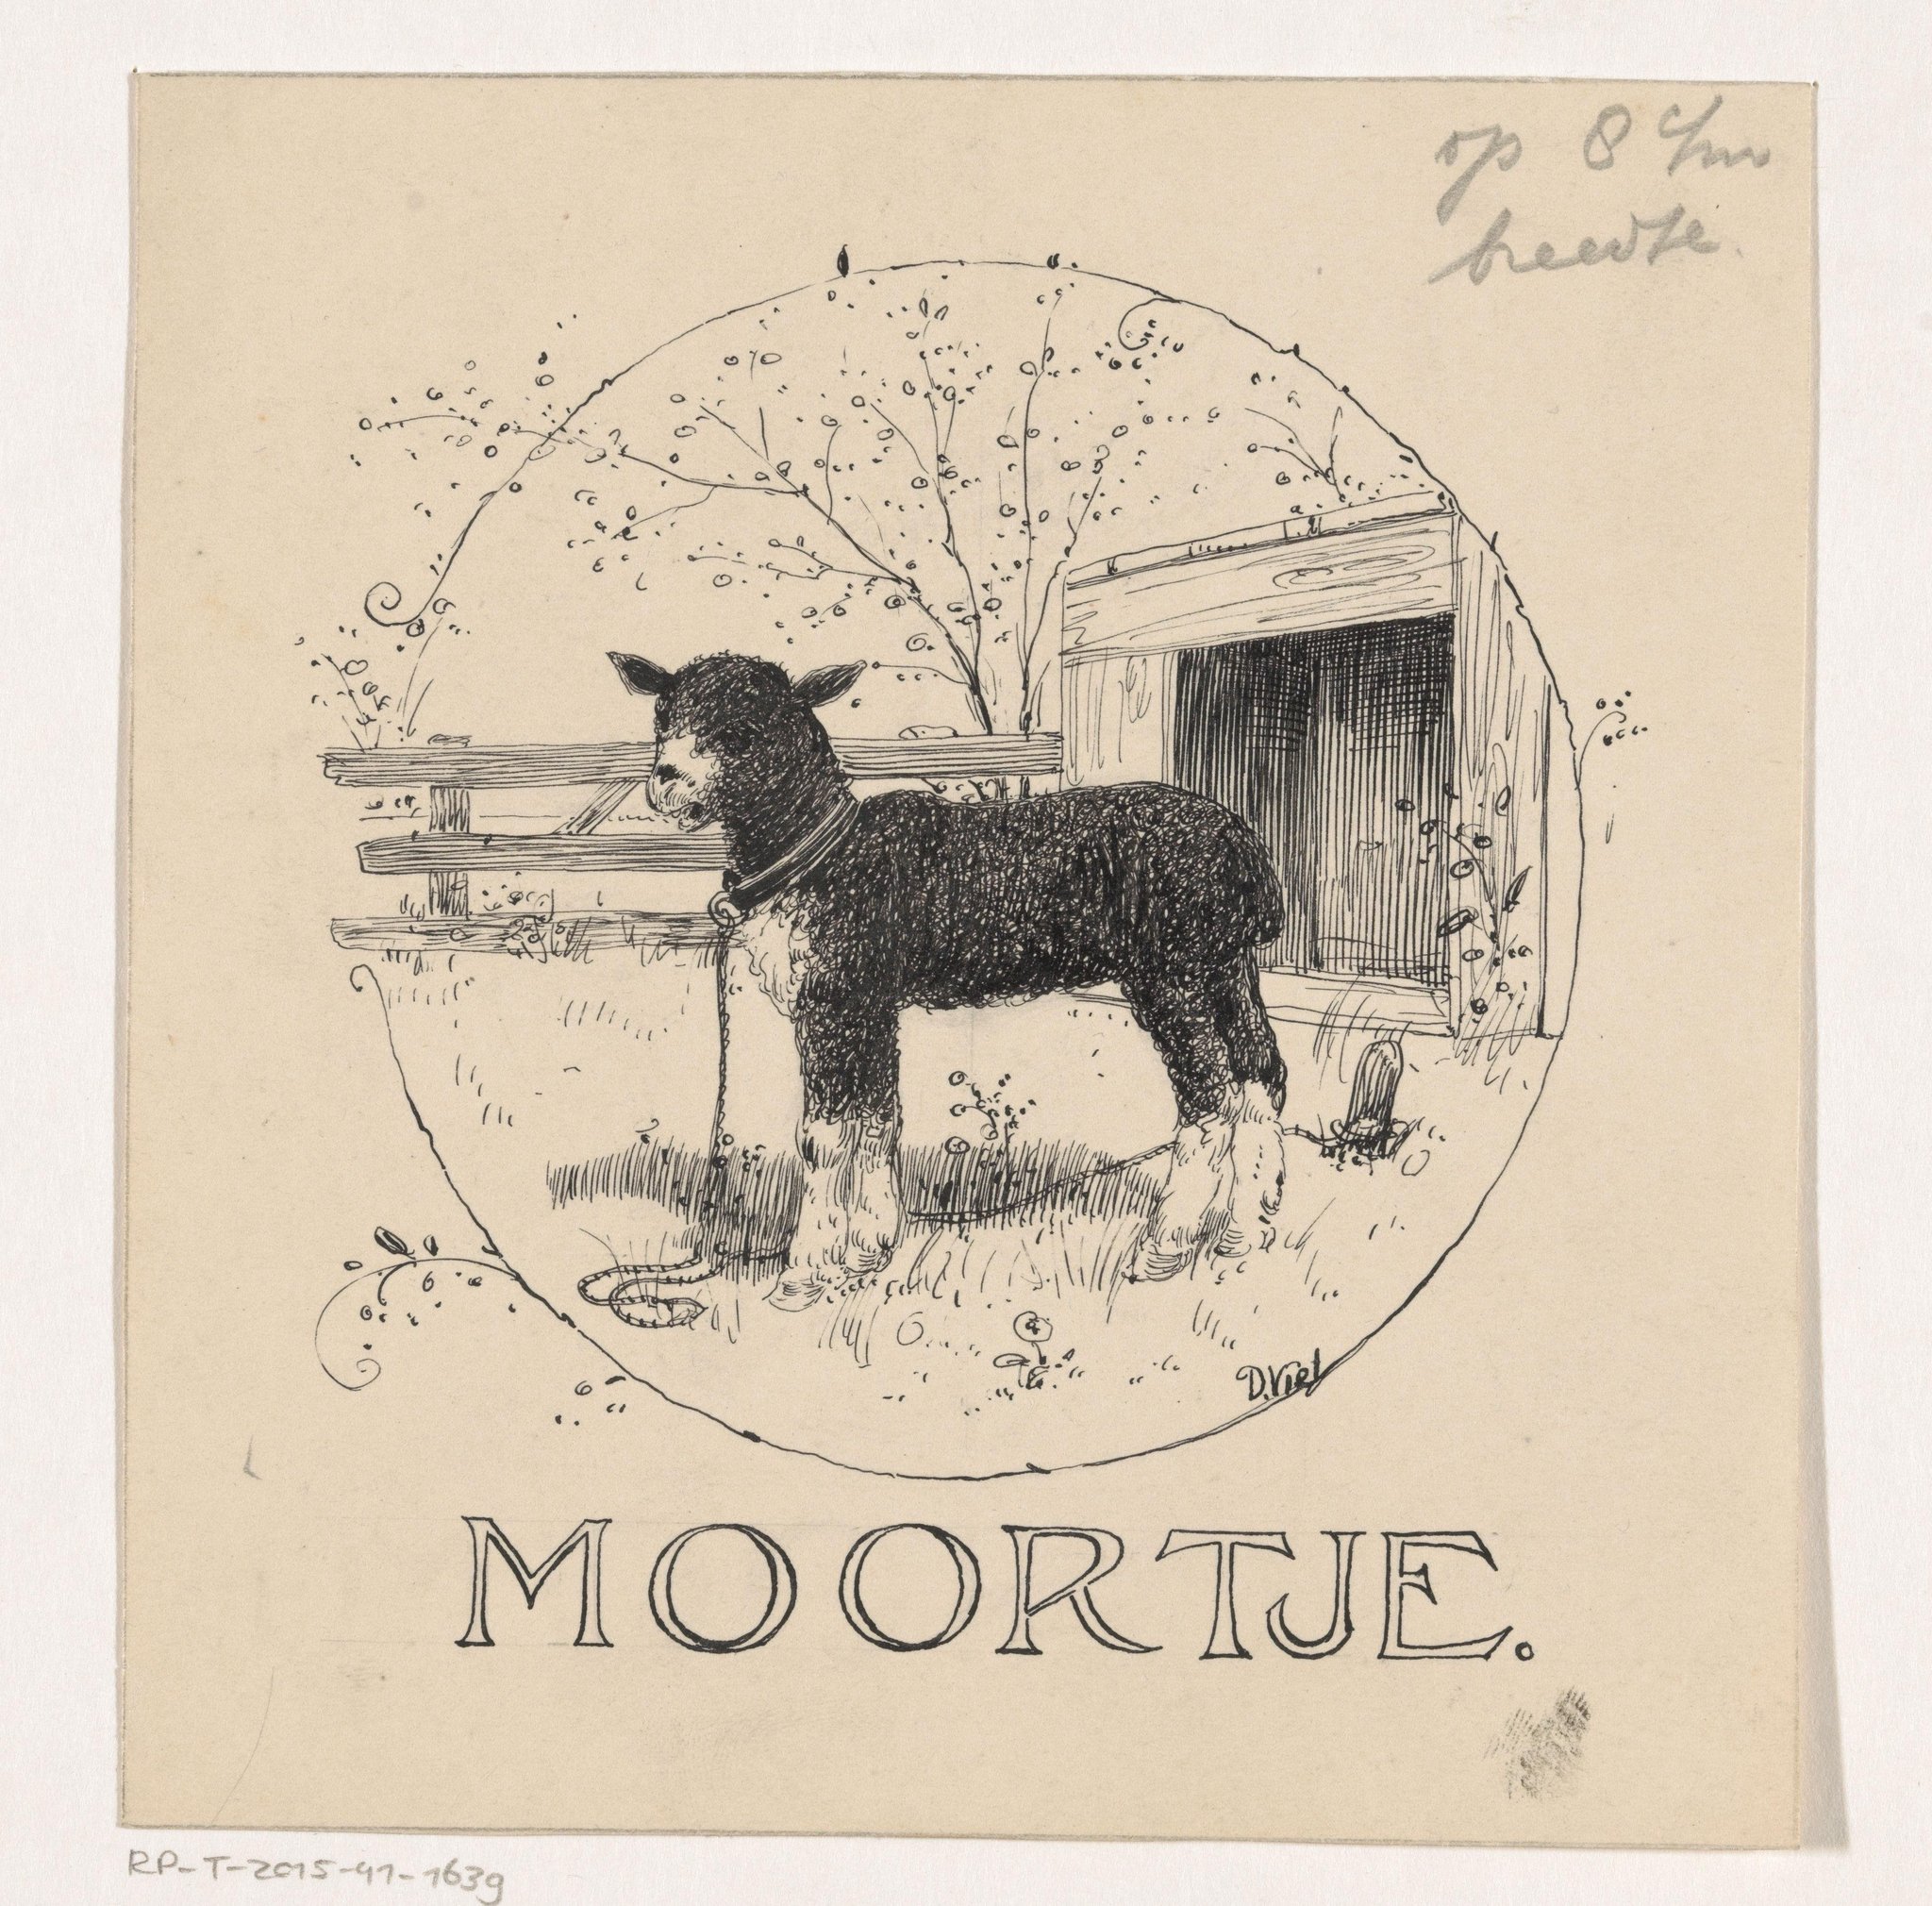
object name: drawing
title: Schaap in een wei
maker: d. viel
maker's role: draughtsman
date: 1915-1935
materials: ink, paper, pencil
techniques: pen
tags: sheep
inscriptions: :, collector's mark: Lugt 2228, signature: ‘D.Viel’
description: Een schaap met een zwart-wit gekleurde vacht staat in een omheinde wei aan een ketting.